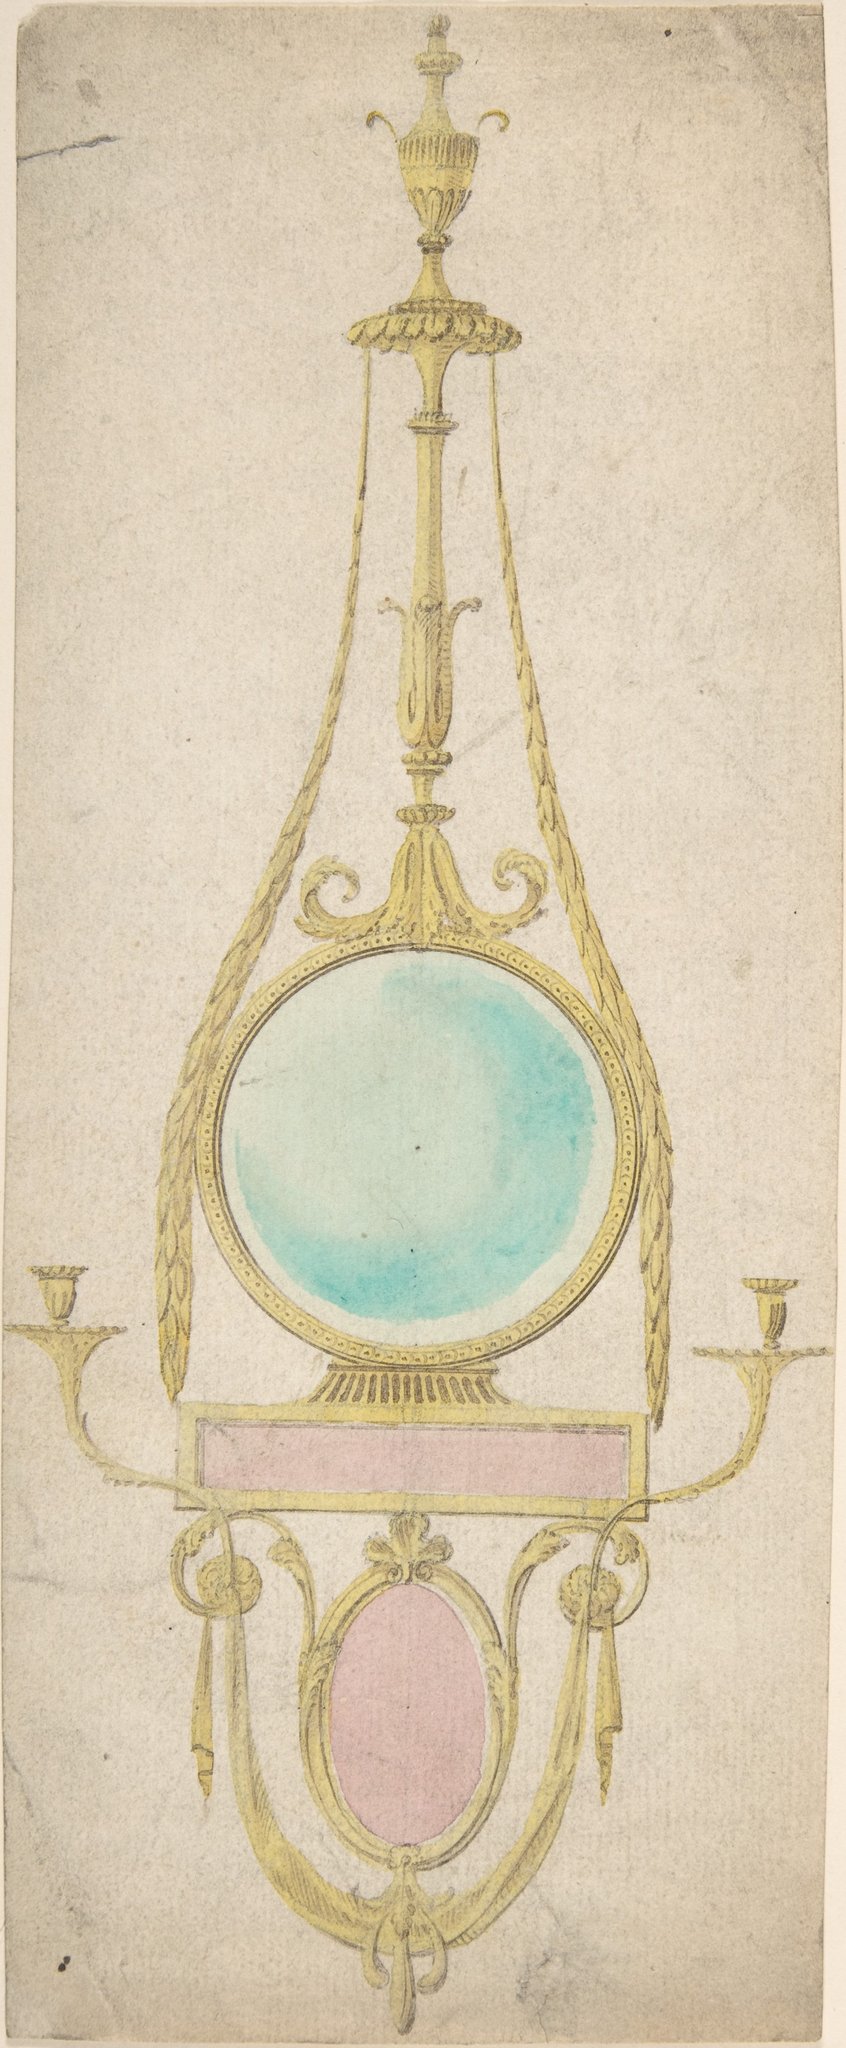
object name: drawing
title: Design for a Girandole with a Circular and Oval Glass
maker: sir william chambers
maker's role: artist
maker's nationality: british, born sweden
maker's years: 1723-1796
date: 1745-1800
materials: ink, watercolor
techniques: pen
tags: mirrors